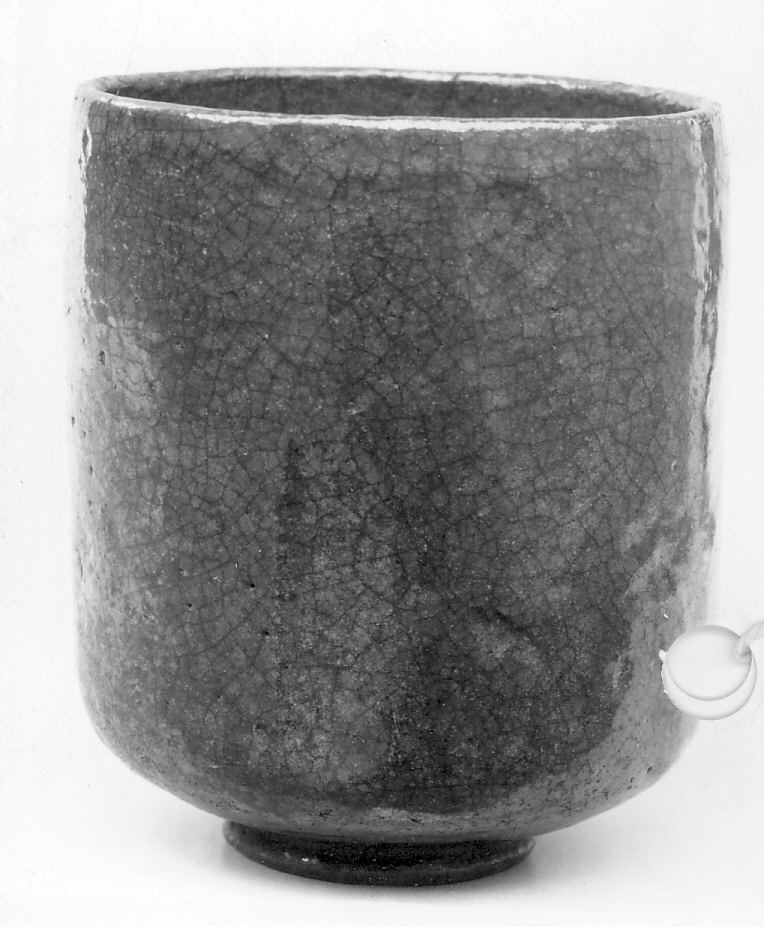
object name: teabowl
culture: japanese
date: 1830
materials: clay, glaze